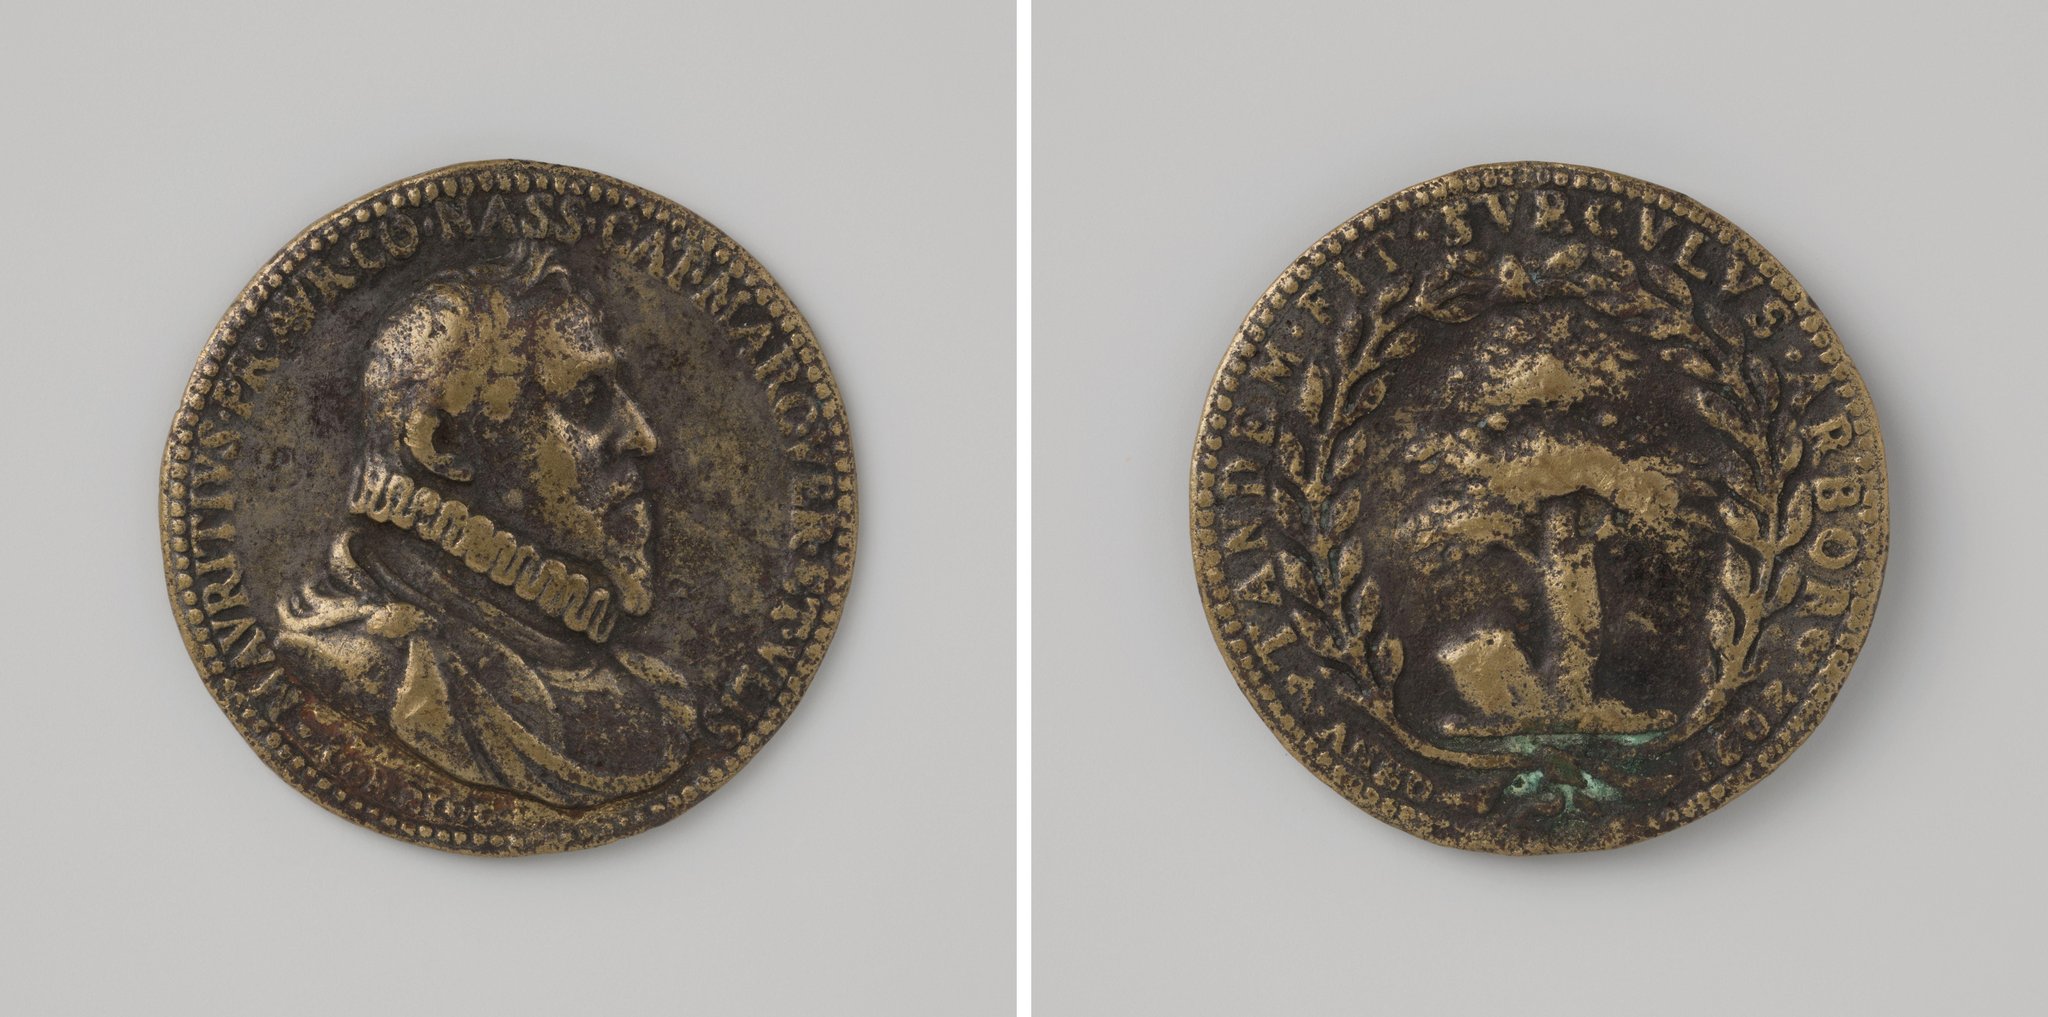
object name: history medal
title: Stadhouder Prins Maurits van Oranje 1602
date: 1602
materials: brass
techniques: casting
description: Messing penning, op de voorzijde het portret van Prins maurits, met omschrift, op de keerzijde een nieuwe loot aan een oranjeboom binnen een lauwerkrans, met omschrift.